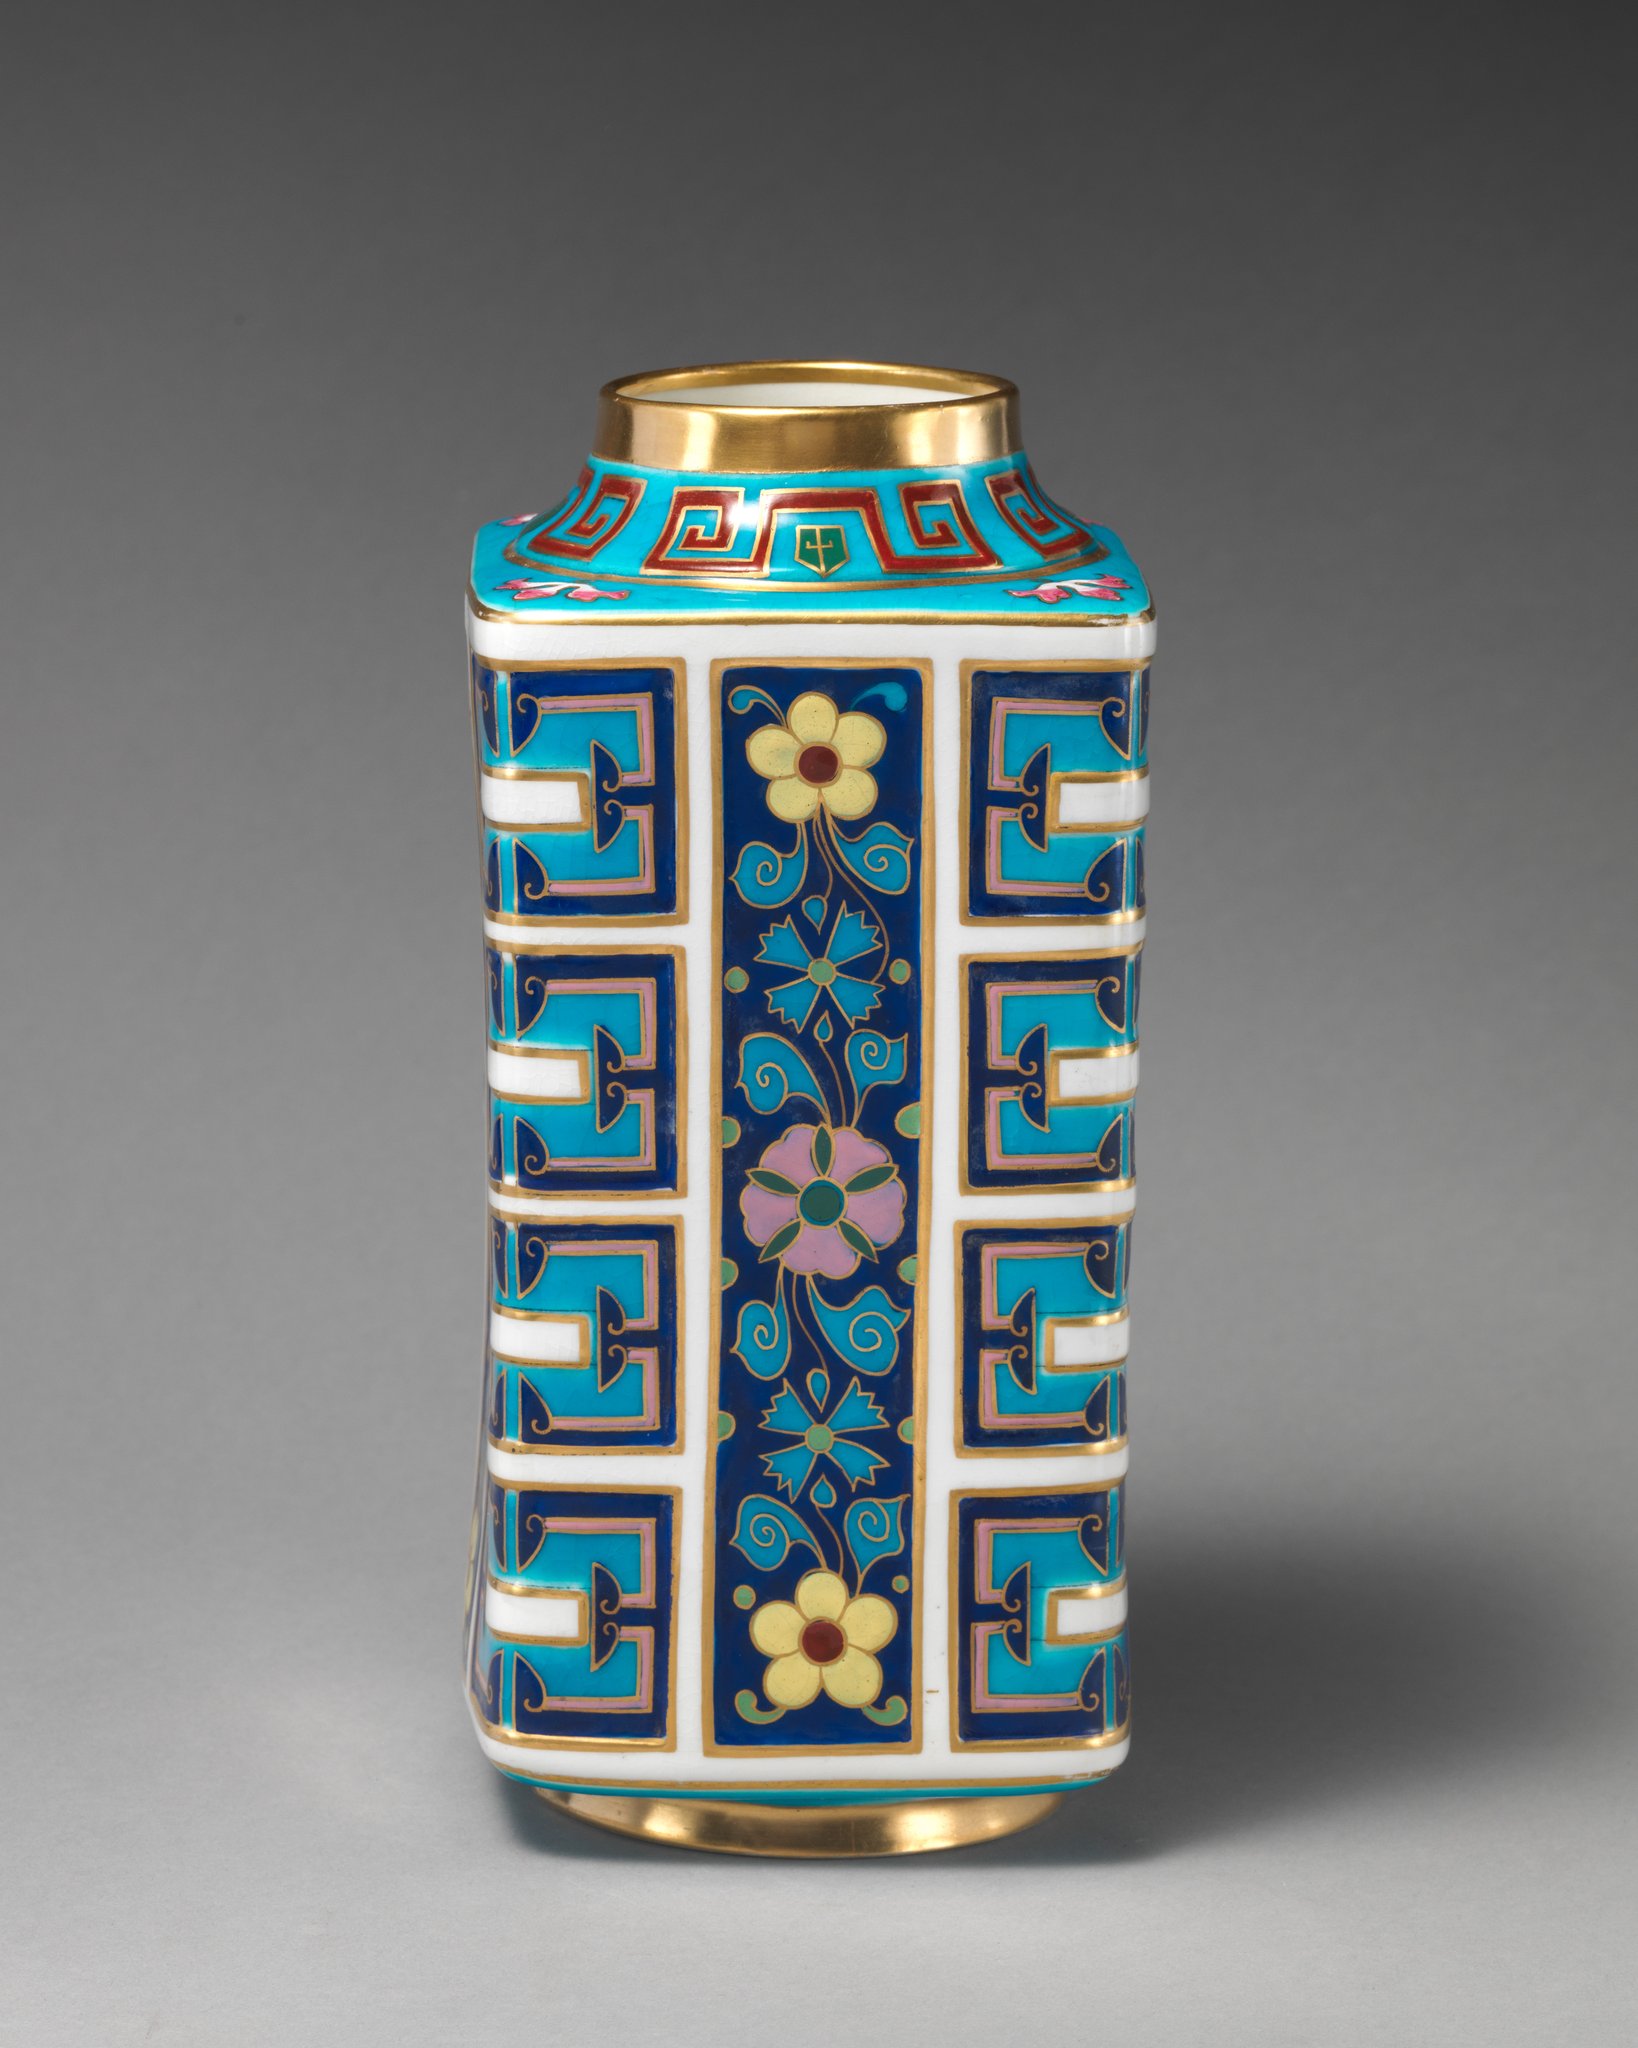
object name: vase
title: Cuboid vase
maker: minton(s)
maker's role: maker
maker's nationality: british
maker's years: 1793-2001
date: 1870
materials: bone china